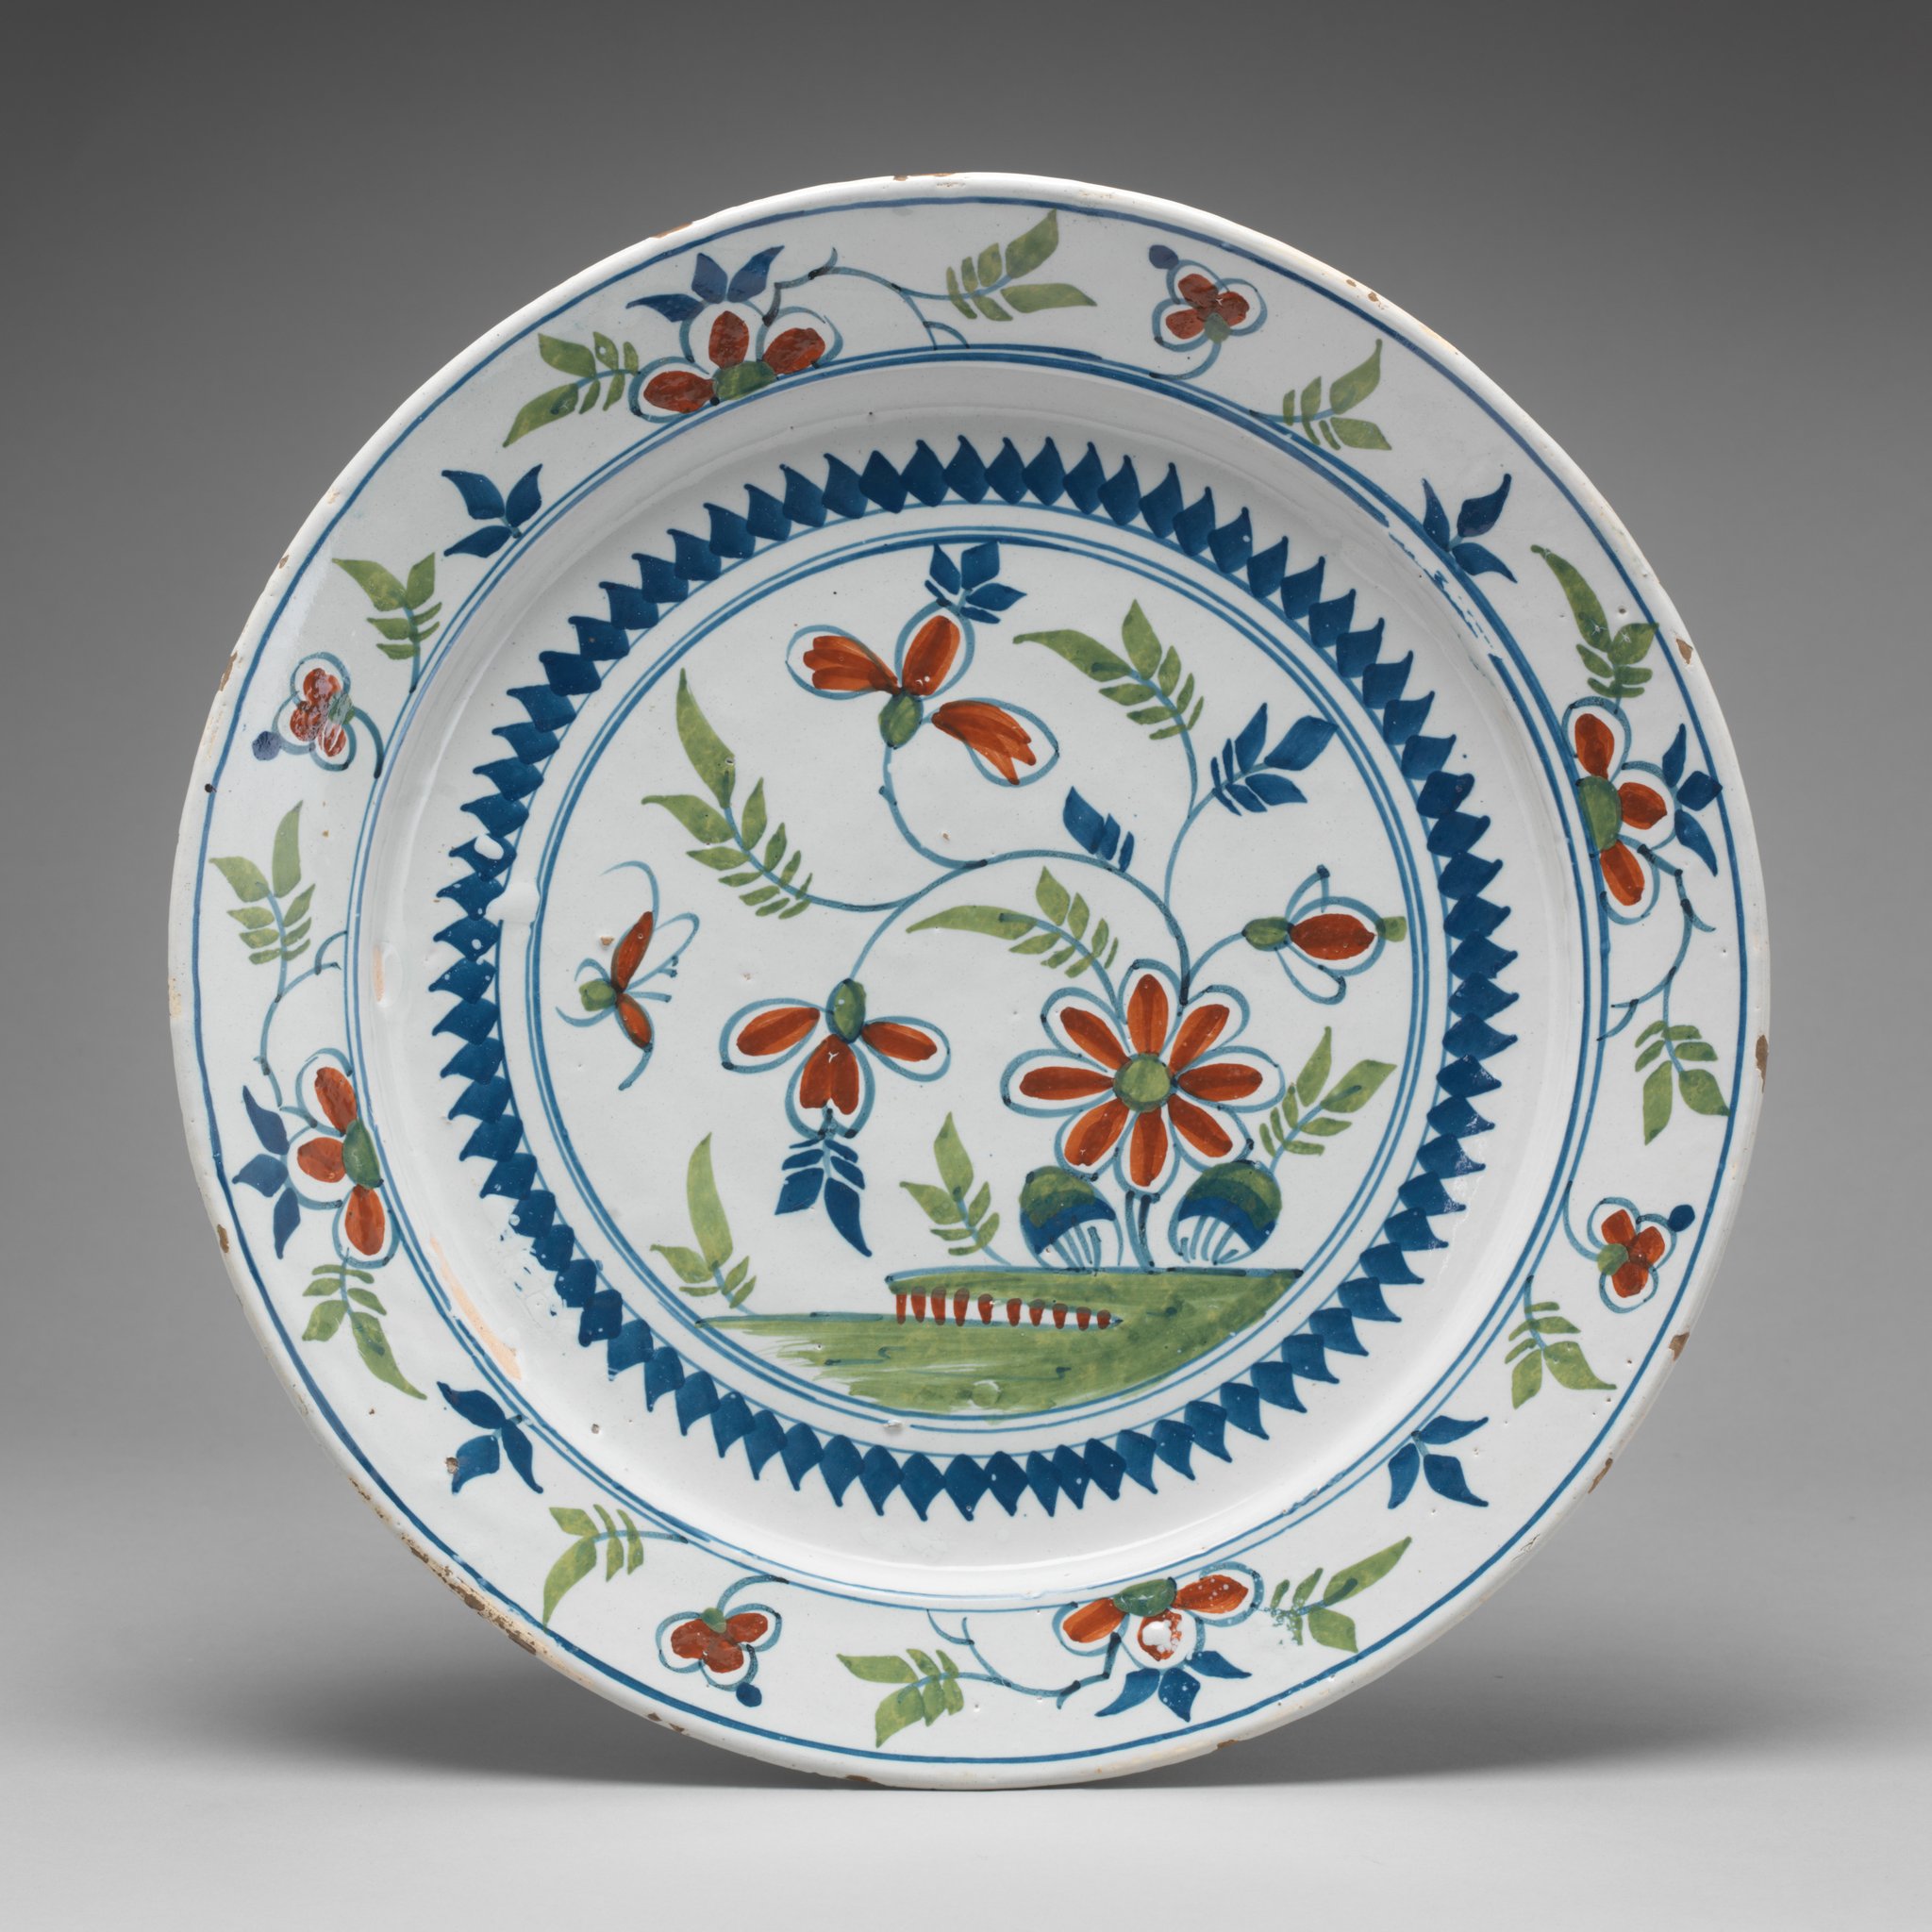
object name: dish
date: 1730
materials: earthenware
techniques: glazing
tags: flowers